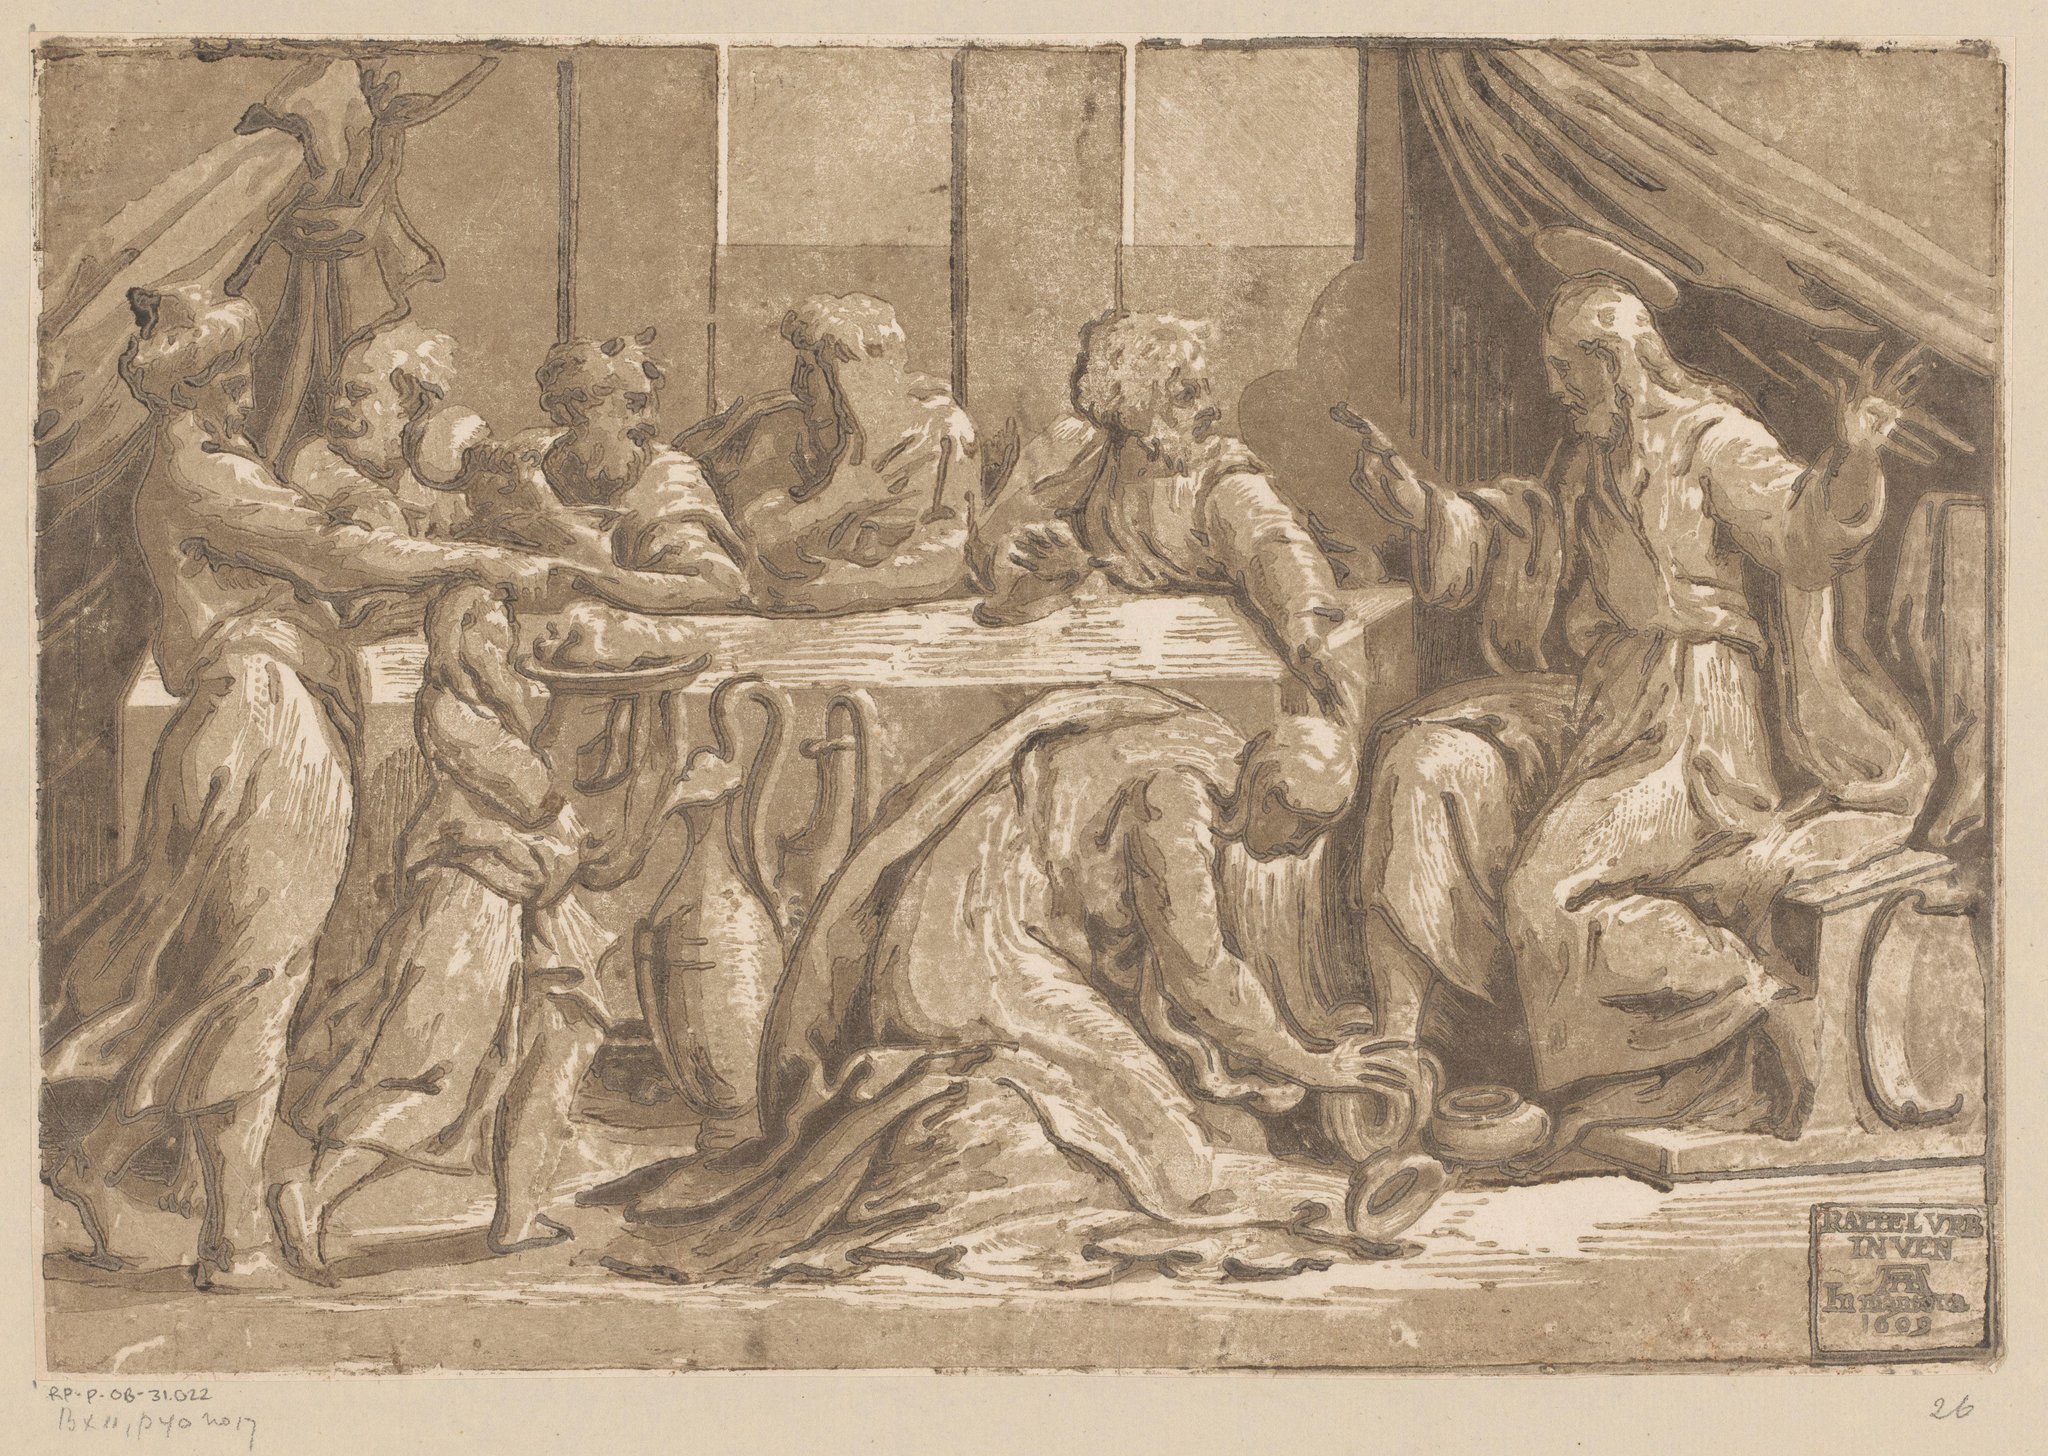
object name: print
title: Christus gezalfd door Maria Magdalena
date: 1609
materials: paper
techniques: woodcut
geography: italy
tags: christ's feet are anointed by mary (magdalene)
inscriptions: collector's mark: Lugt 240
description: Christus zit aan tafel te eten in het huis van Simon de Farizeeër. Maria Magdalena knielt op de grond zalft zijn voeten en droogt ze met haar haren.